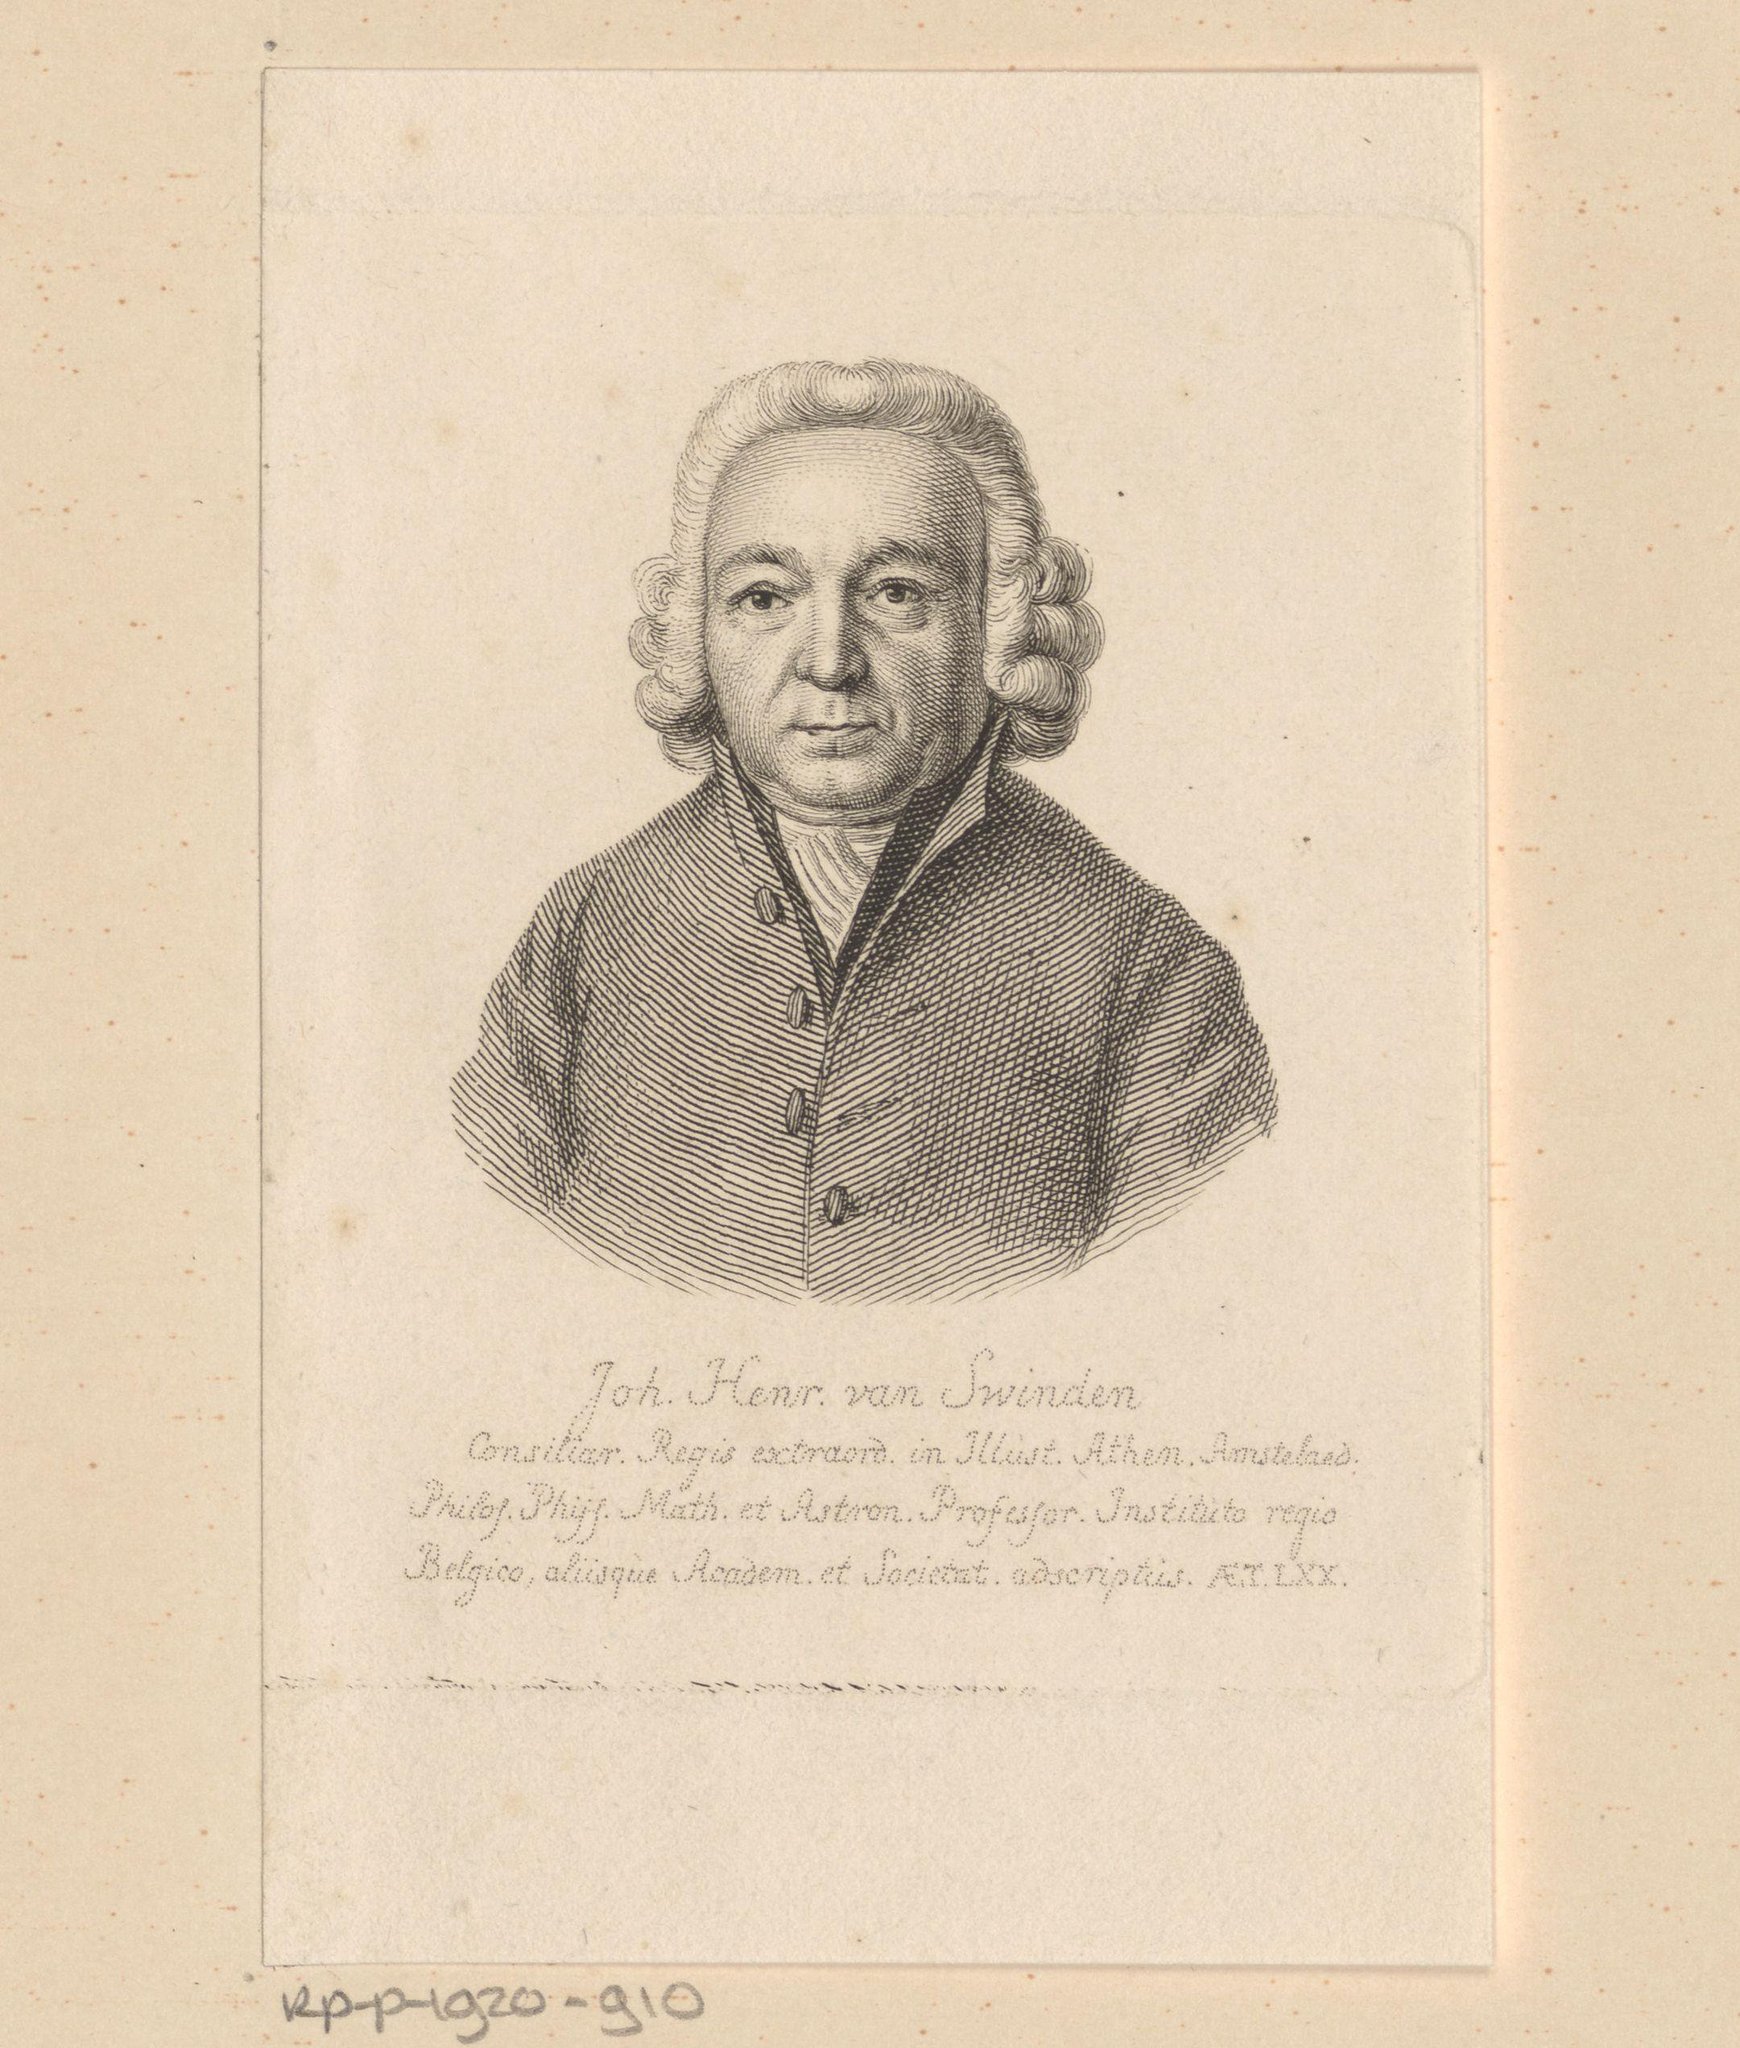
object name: print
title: Studie-prentwerk / Etudes gravées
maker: jacob ernst marcus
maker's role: draughtsman, print maker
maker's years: 1774-1826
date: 1816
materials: paper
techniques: etching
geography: amsterdam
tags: the hague, physicist, jean henri van swinden, historical persons, portrait of a writer, professor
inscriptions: collector's mark: Lugt 2228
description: De prenten verschenen eerst maandelijks tussen november 1807 en juli 1816. Later gebundeld uitgegeven als: Studie-prentwerk/ Etudes gravées, ca. 1817. In 1834 volgde nog een heruitgave. Prent is afgesneden van een grotere prent met twee portretten, zie RP-P-1904-2166.